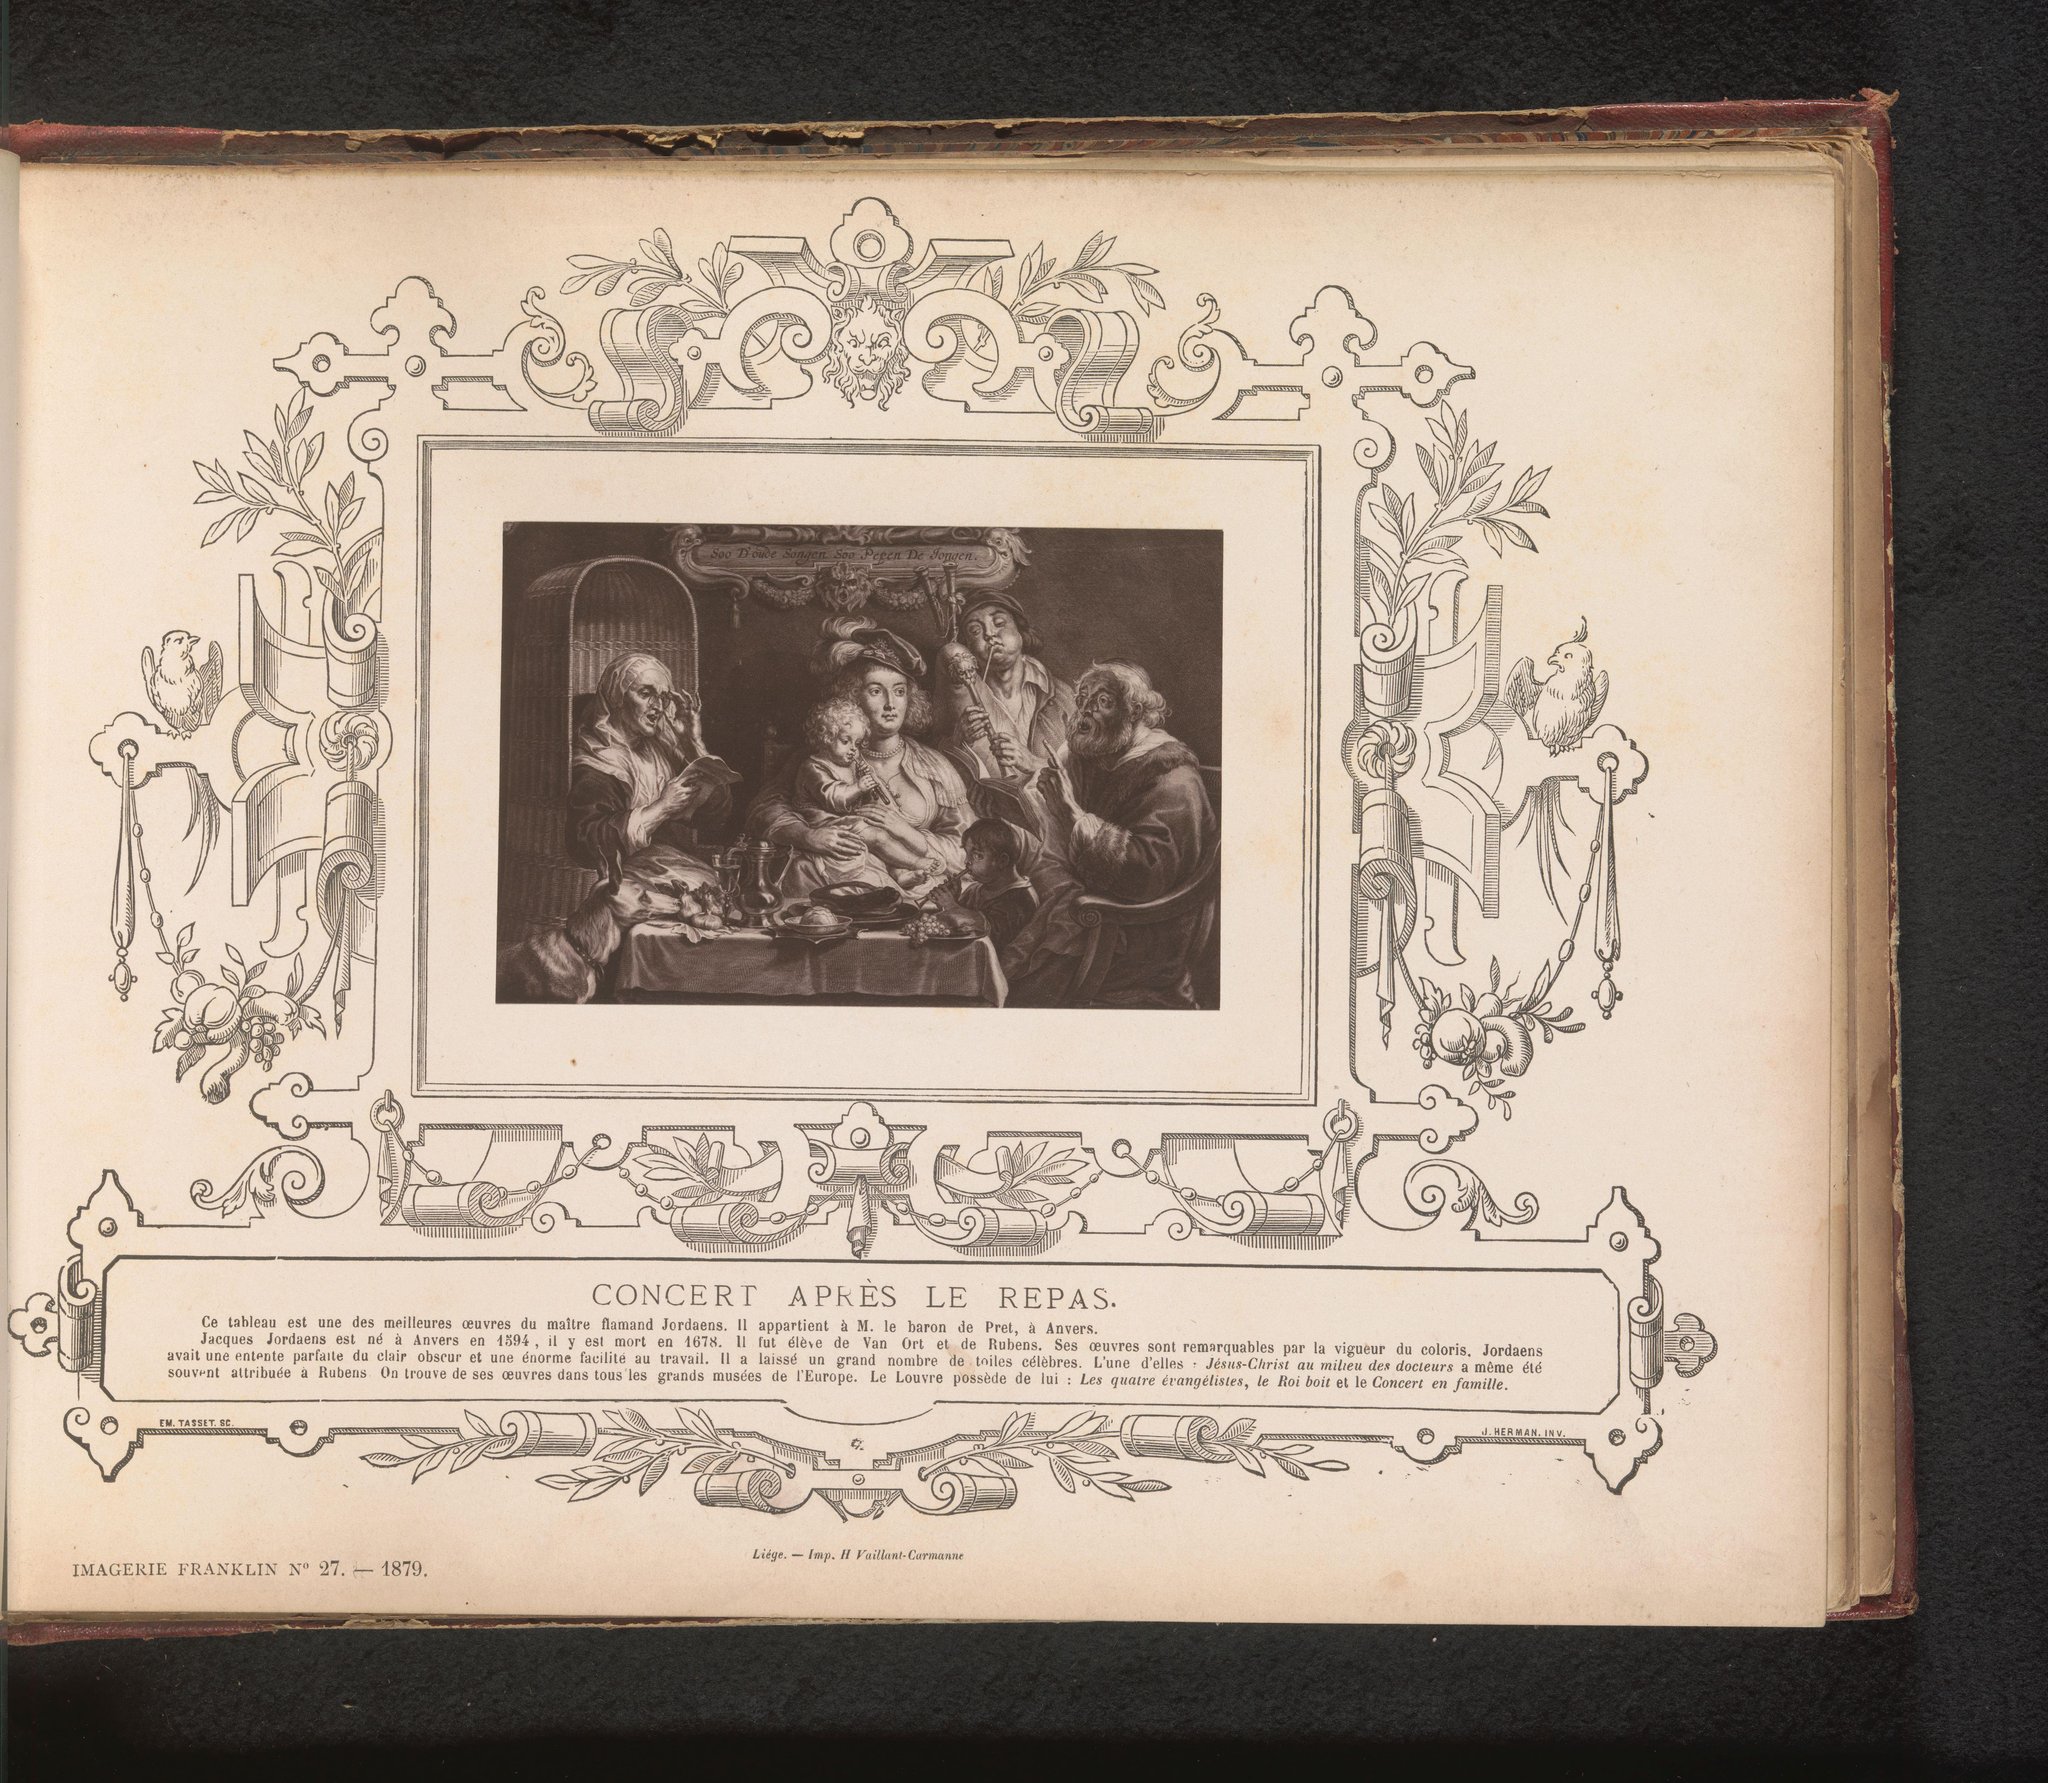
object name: page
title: Reproductie van Het Familieconcert door Peter Paul Rubens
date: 1874-1879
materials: paper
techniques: woodburytype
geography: liège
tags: family life at home, more than one musician with instrument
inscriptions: inscription: ‘IMAGERIE FRANKLIN No 27. -1879.’, inscription: ‘Ce tableau (...) en famille.’, name: ‘J. HERMAN, INV.’, name: ‘EM. TASSET, SC.’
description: Deze prent maakt deel uit van een album.